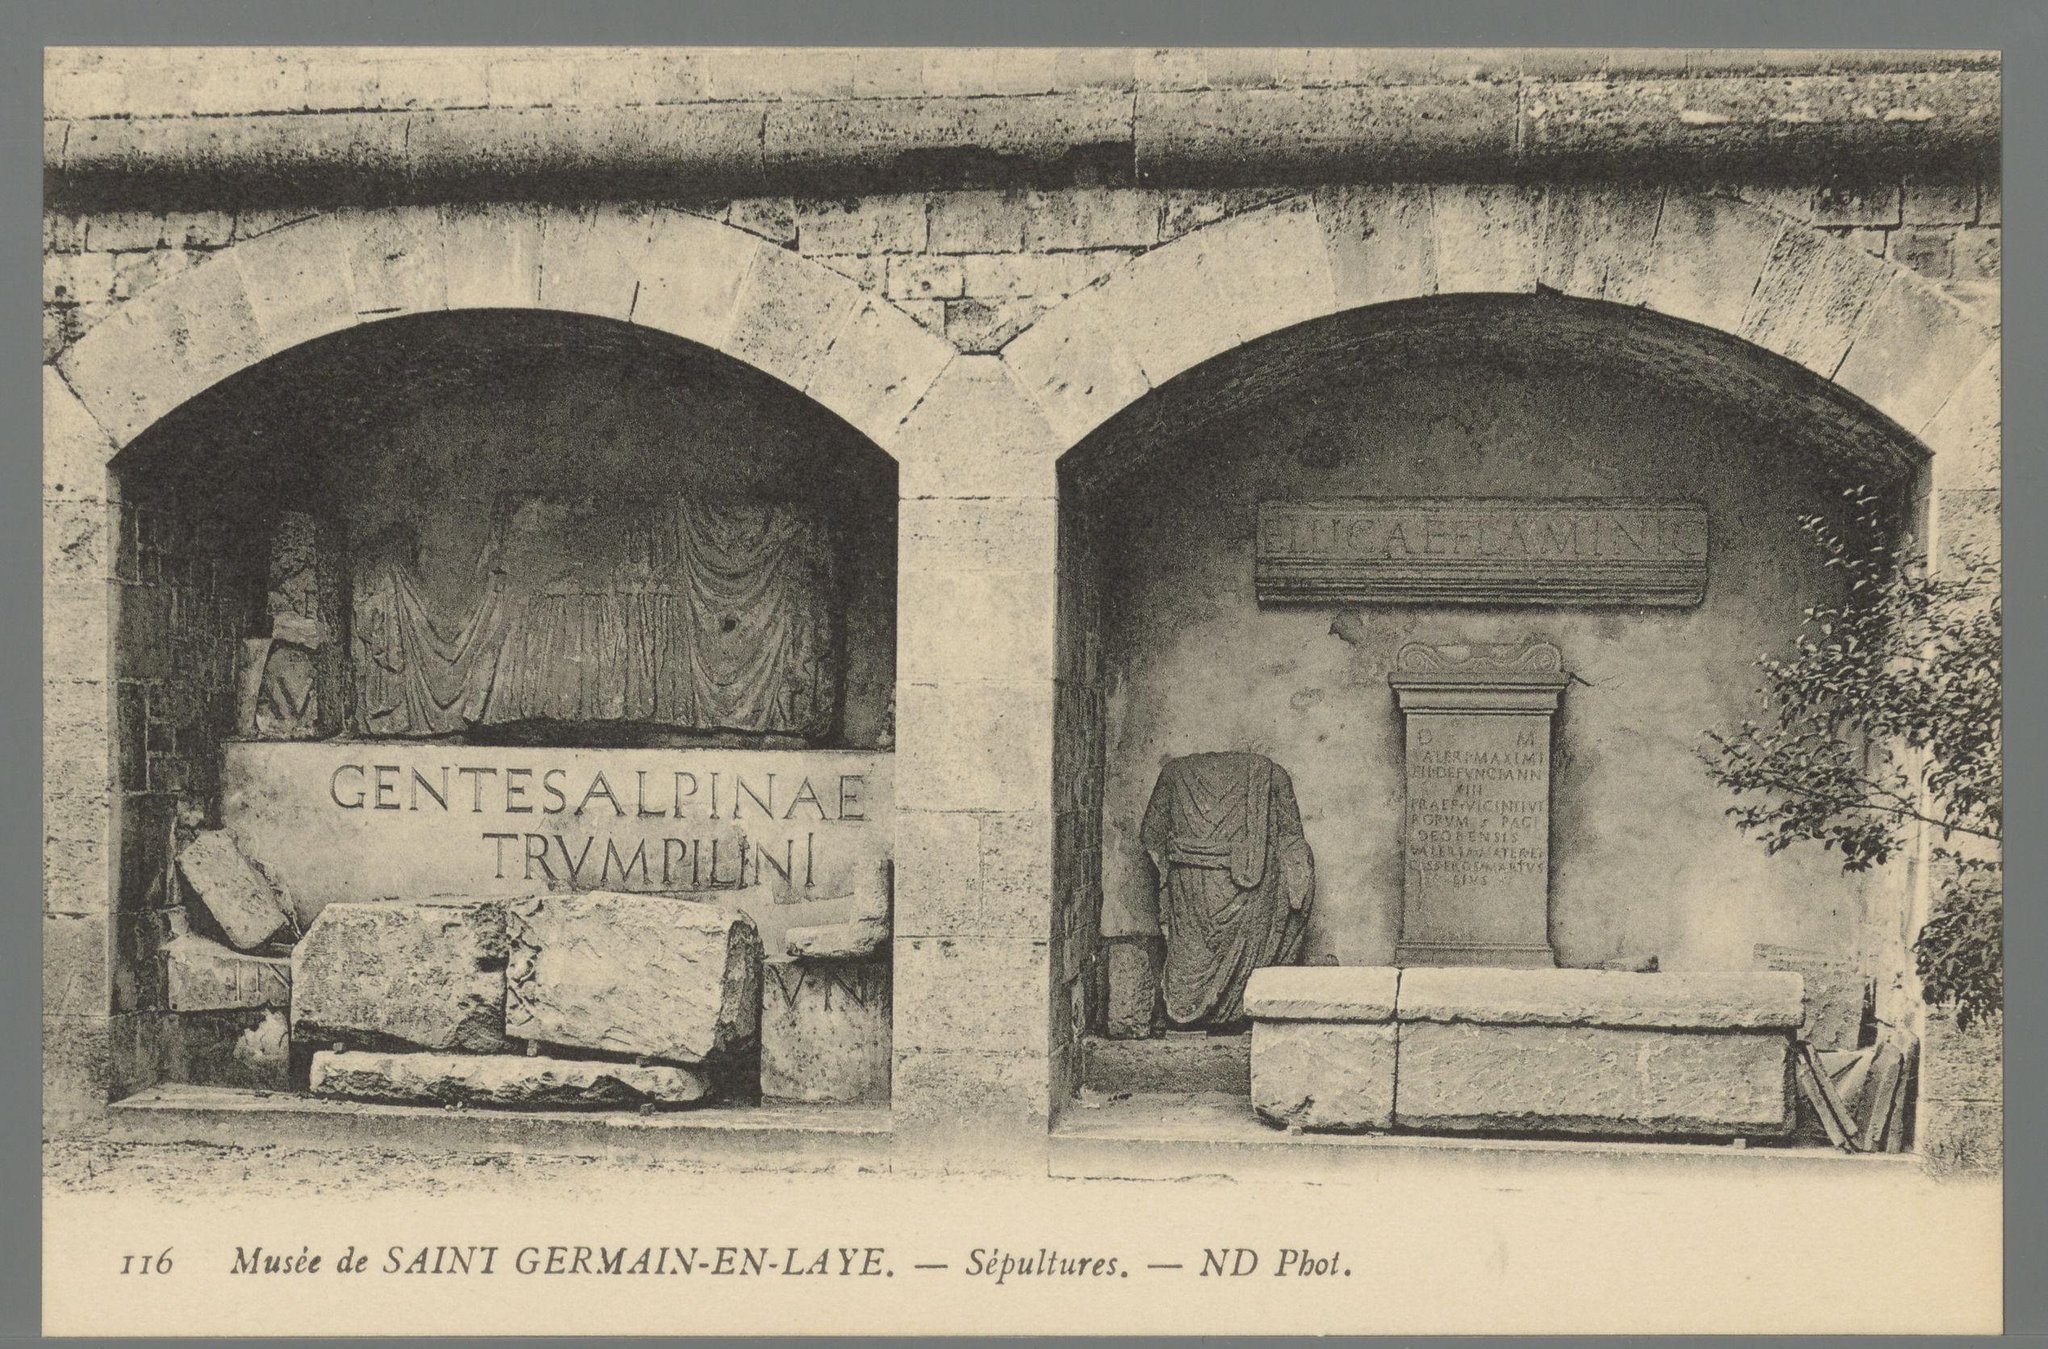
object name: photomechanical print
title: Sépultures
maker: Anonymous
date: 1903-1918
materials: cardboard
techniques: photograph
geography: paris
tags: grave, tomb, permanent exhibition, museum